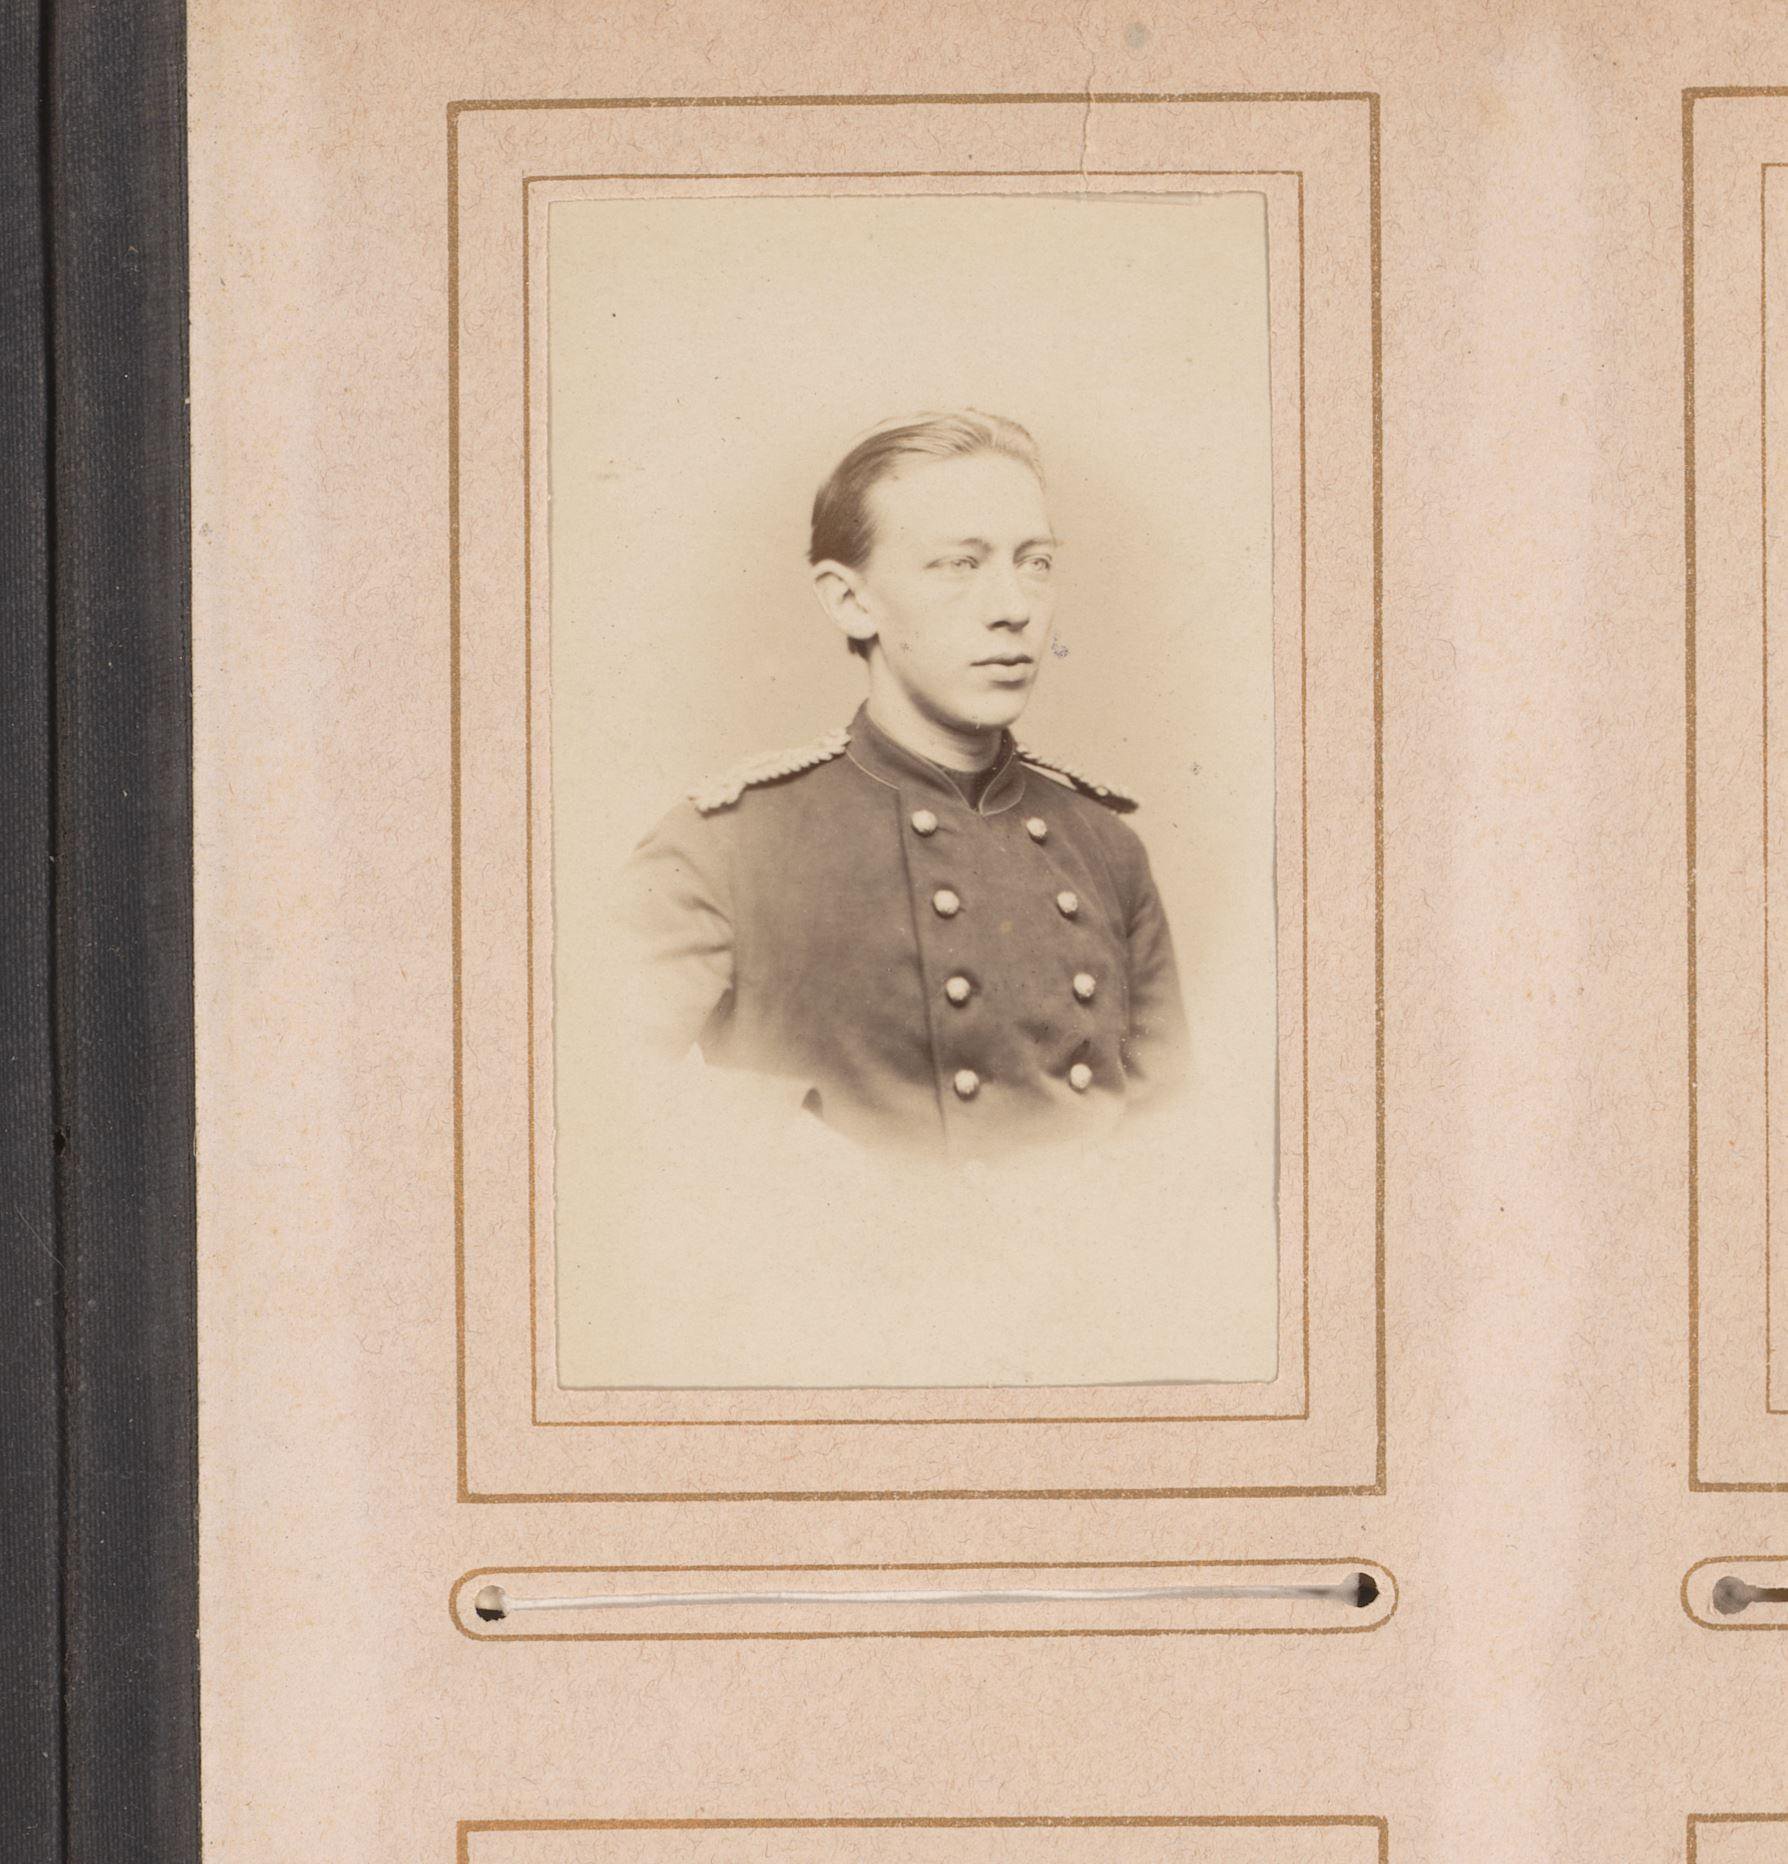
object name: album leaf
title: Portret van een man in uniform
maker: albert greiner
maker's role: fotograaf, fotostudio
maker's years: 1833-1890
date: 1861-1874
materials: cardboard, photographic support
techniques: albumen print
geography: amsterdam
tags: historical persons, (military) uniforms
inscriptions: inscription: ‘A. Greiner/ Photograf/ Nieuwendijk L.87/ Amsterdam’